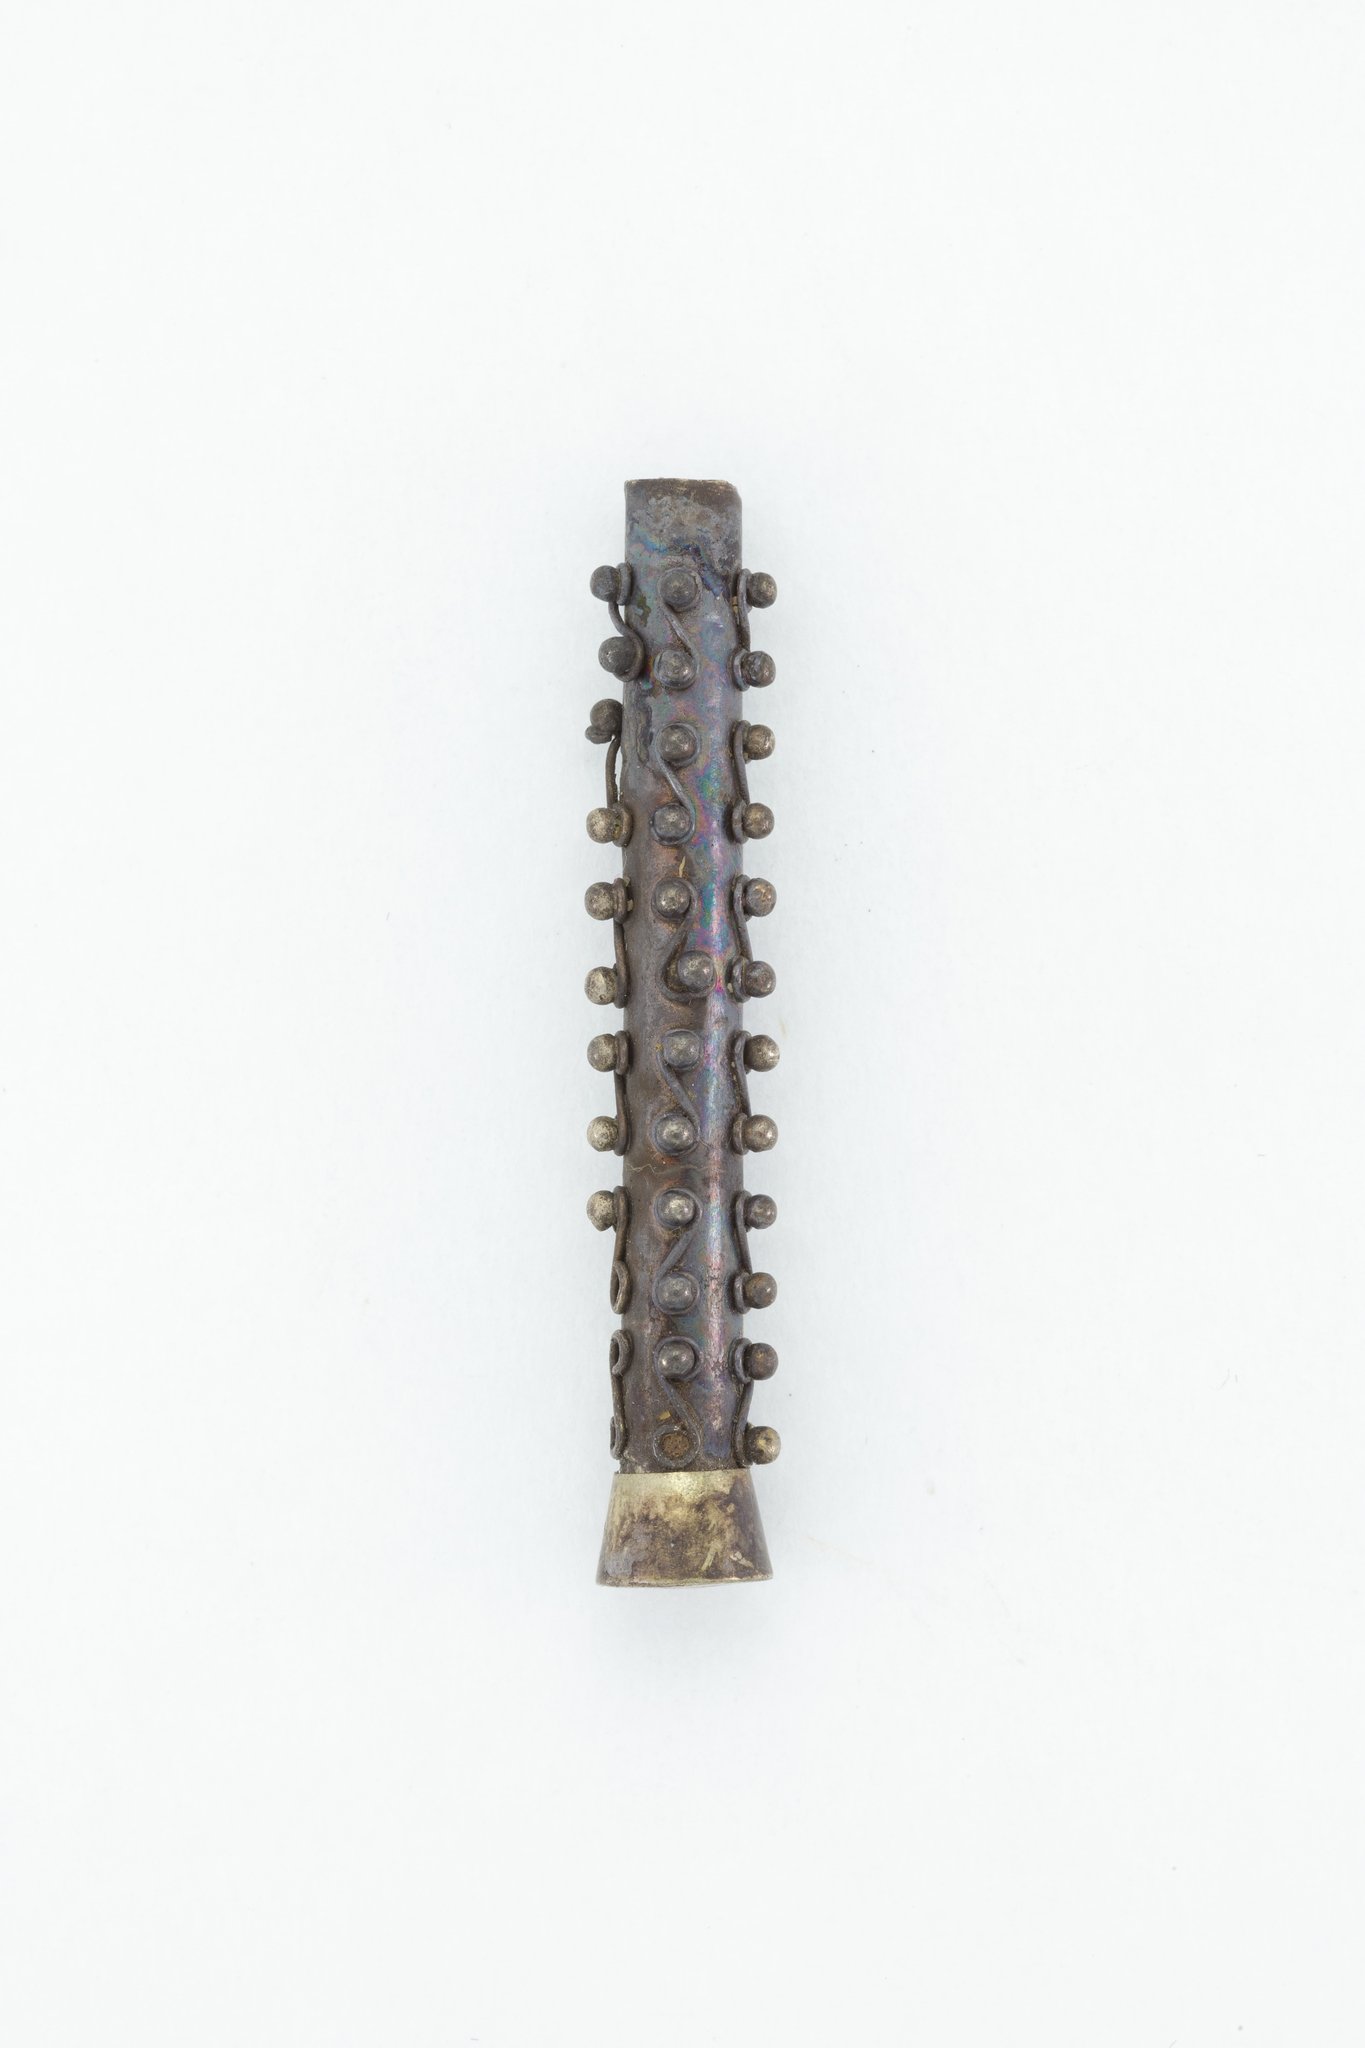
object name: pendant, cylinder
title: Cylindrical pendant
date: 1700-1425 BCE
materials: silver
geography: egypt